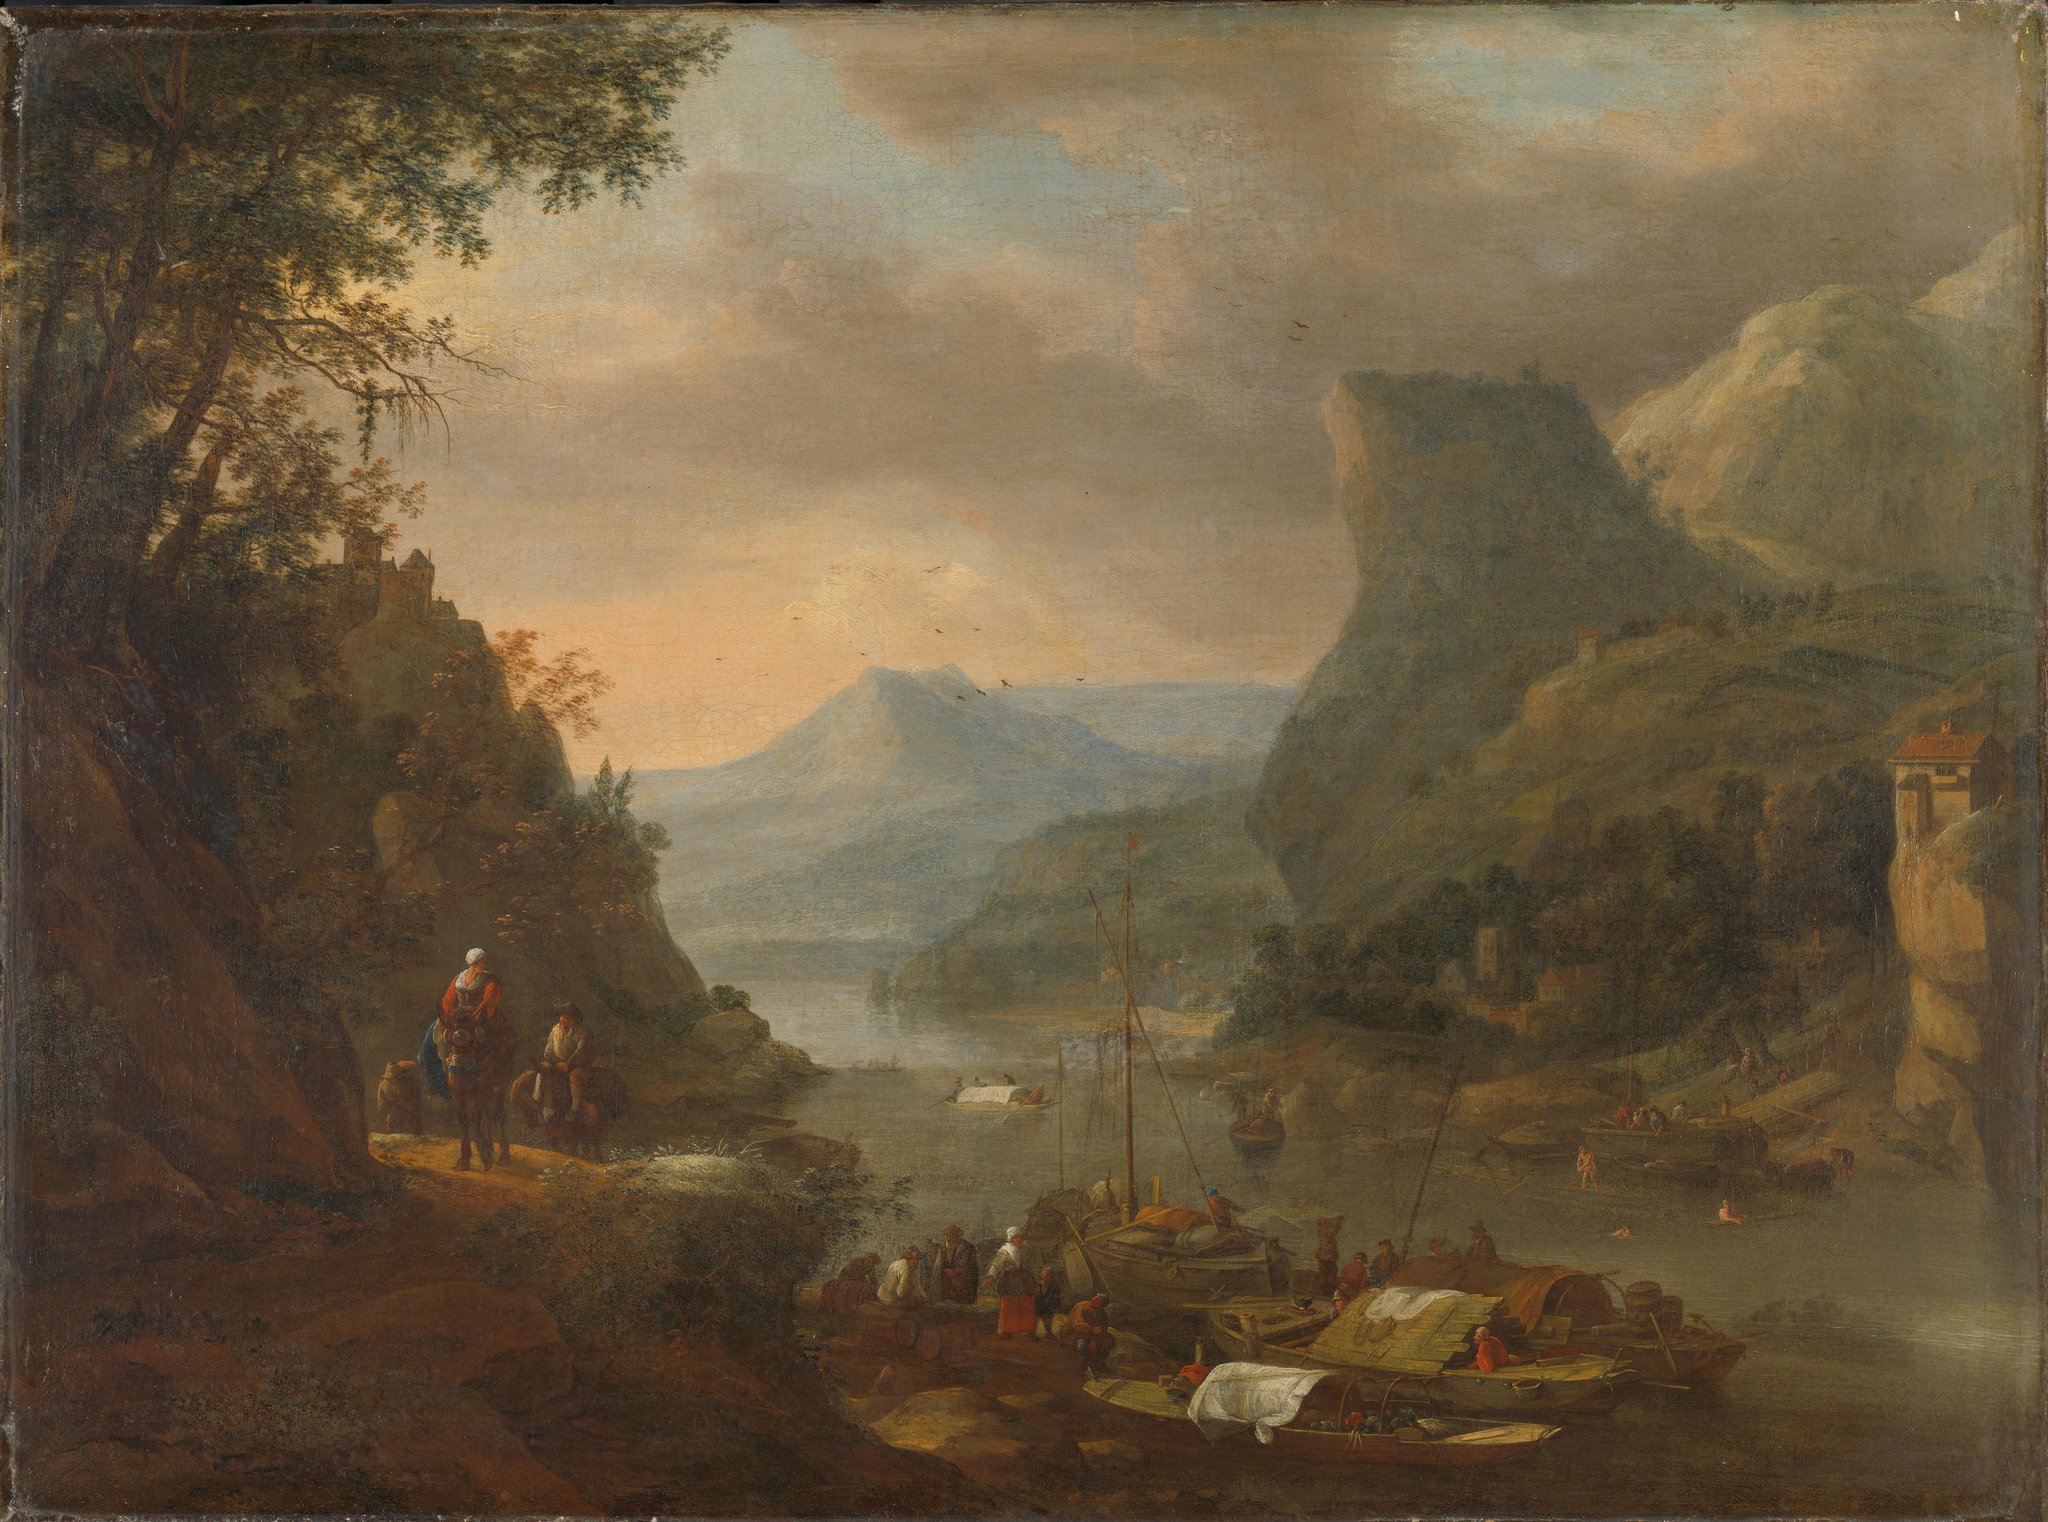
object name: painting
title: River View in a Mountainous Region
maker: herman saftleven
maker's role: draughtsman, painter, print maker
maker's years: 1609-1685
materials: canvas, oil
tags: river, mountains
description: Riviergezicht in een bergachtige streek. Aan de oever van de rivier liggen enkele boten, links gaan reizigers op muilezels over een pad. Aan de overzijde van de rivier steekt een hoge steile rots omhoog.